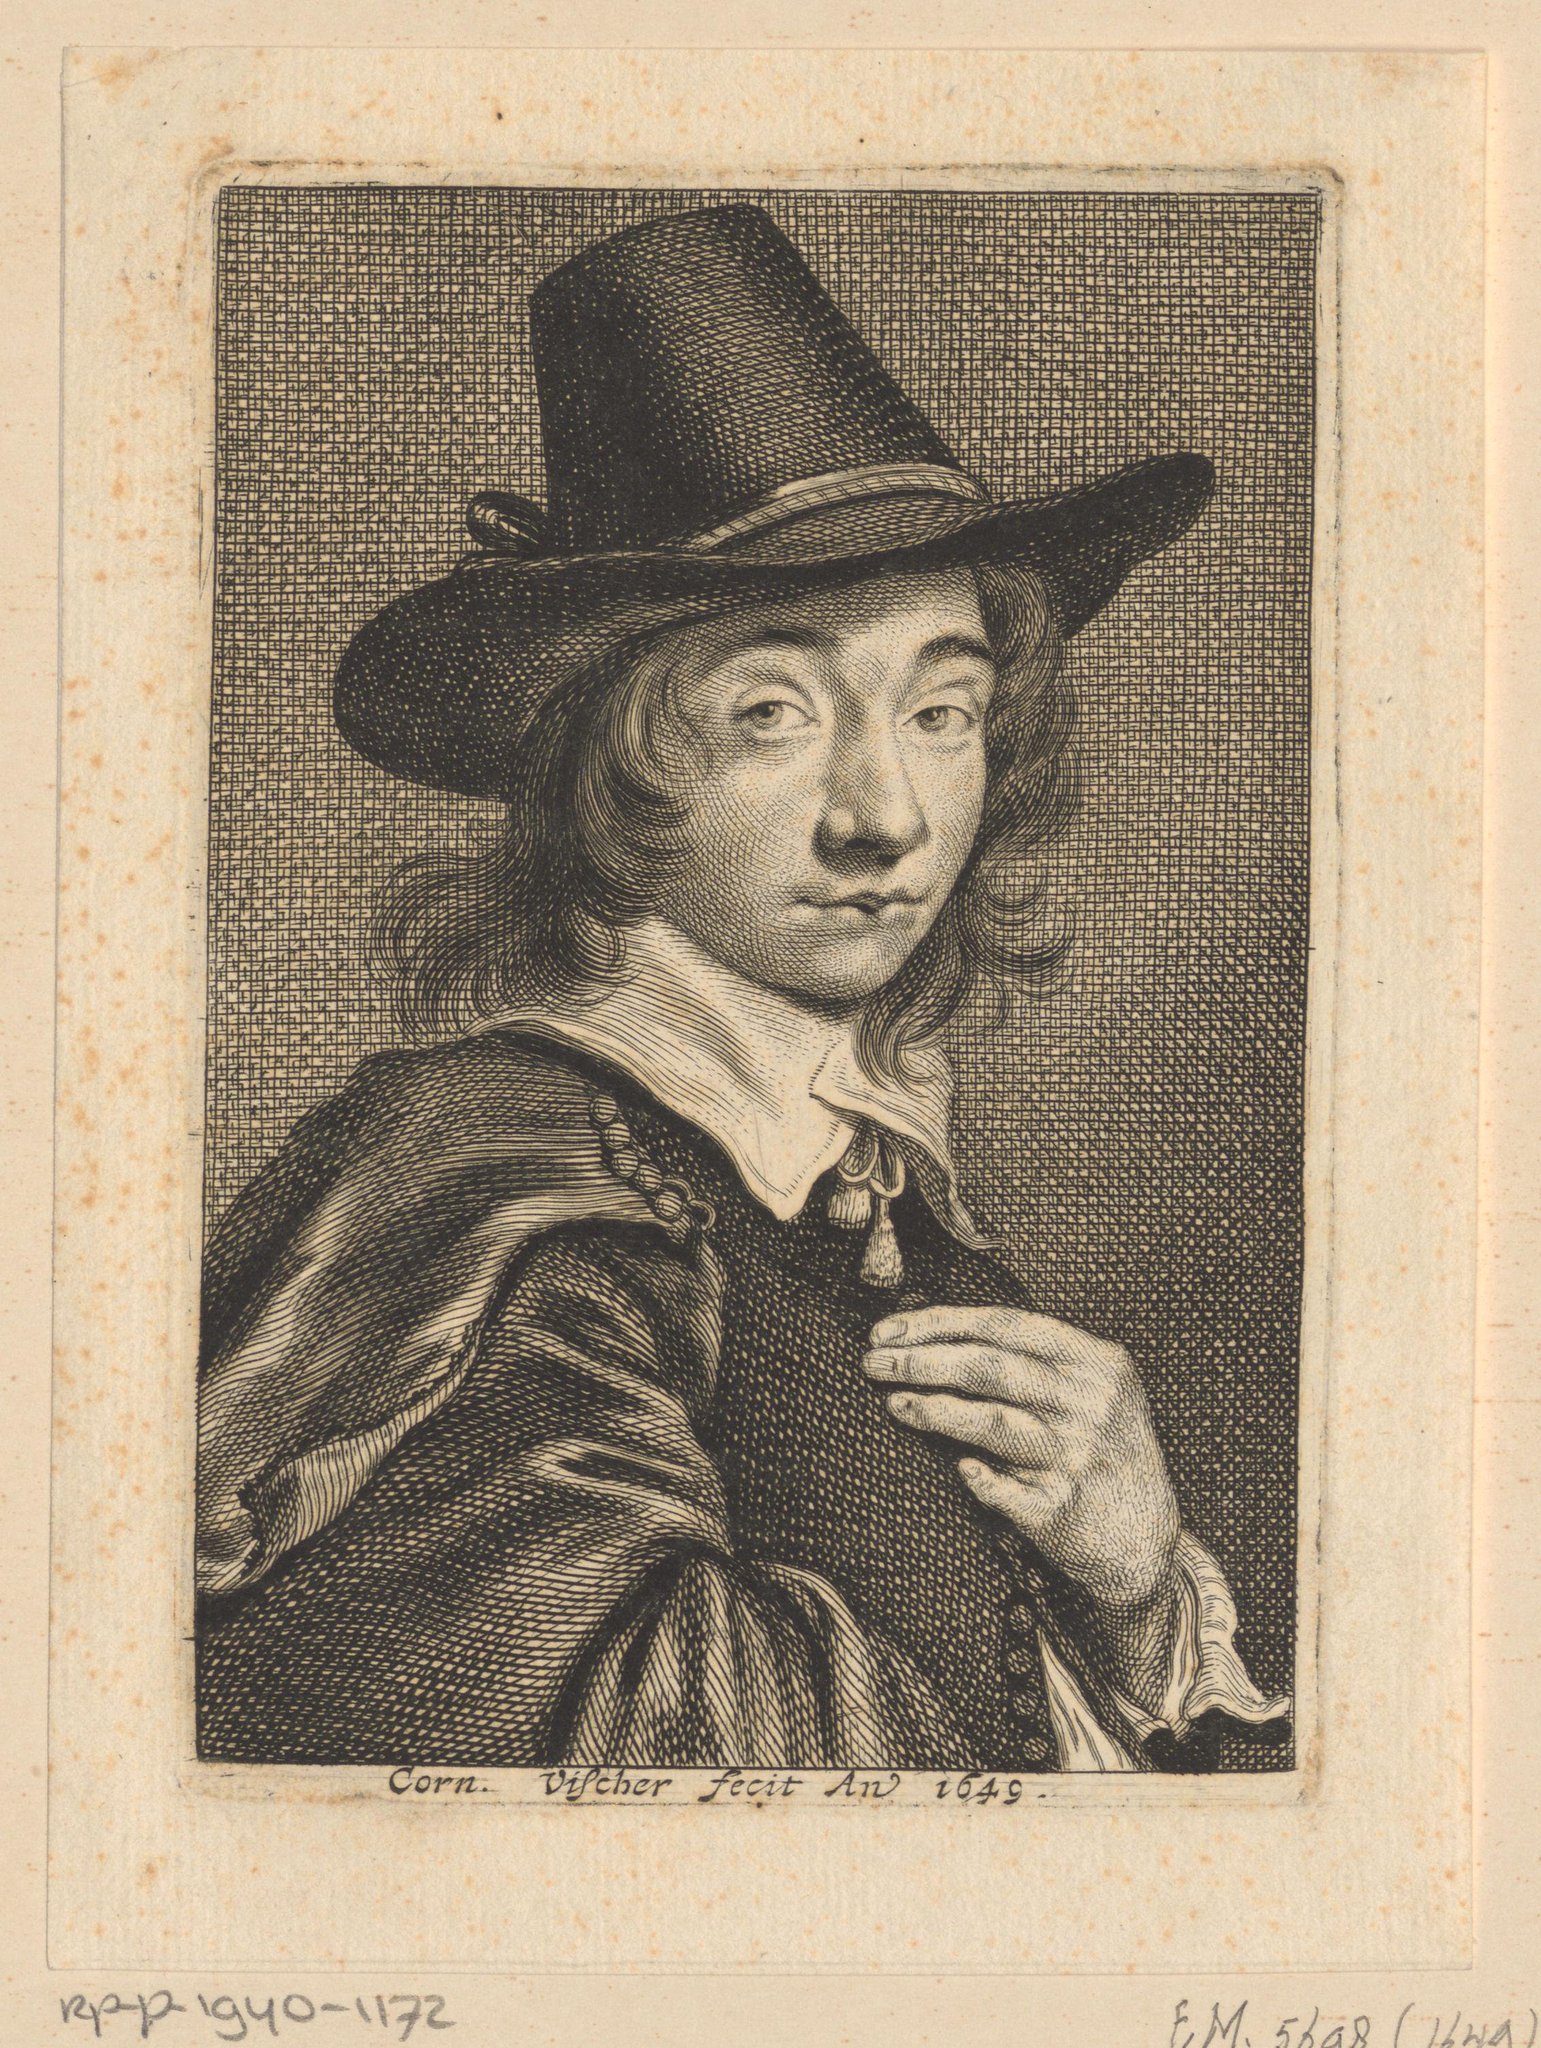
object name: print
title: Zelfportret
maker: cornelis visscher (ii)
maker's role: draughtsman, painter, print maker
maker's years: 1628-1658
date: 1649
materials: paper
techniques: engraving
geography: haarlem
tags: draughtsman, cornelis visscher (ii), historical persons, portrait, self-portrait of painter, portrait, self-portrait of graphic artist, portrait, self-portrait of draughtsman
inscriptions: collector's mark: Lugt 2760, collector's mark: Lugt 2228